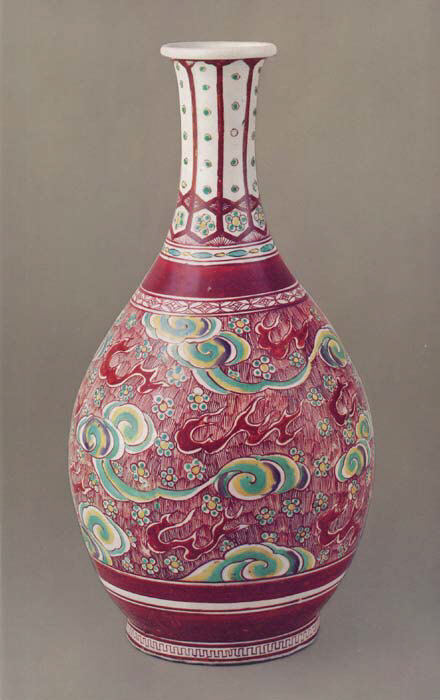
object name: wine bottle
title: Large Wine Bottle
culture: japanese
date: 1634-1666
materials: enamel, porcelain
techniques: overglaze, polychrome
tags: flowers